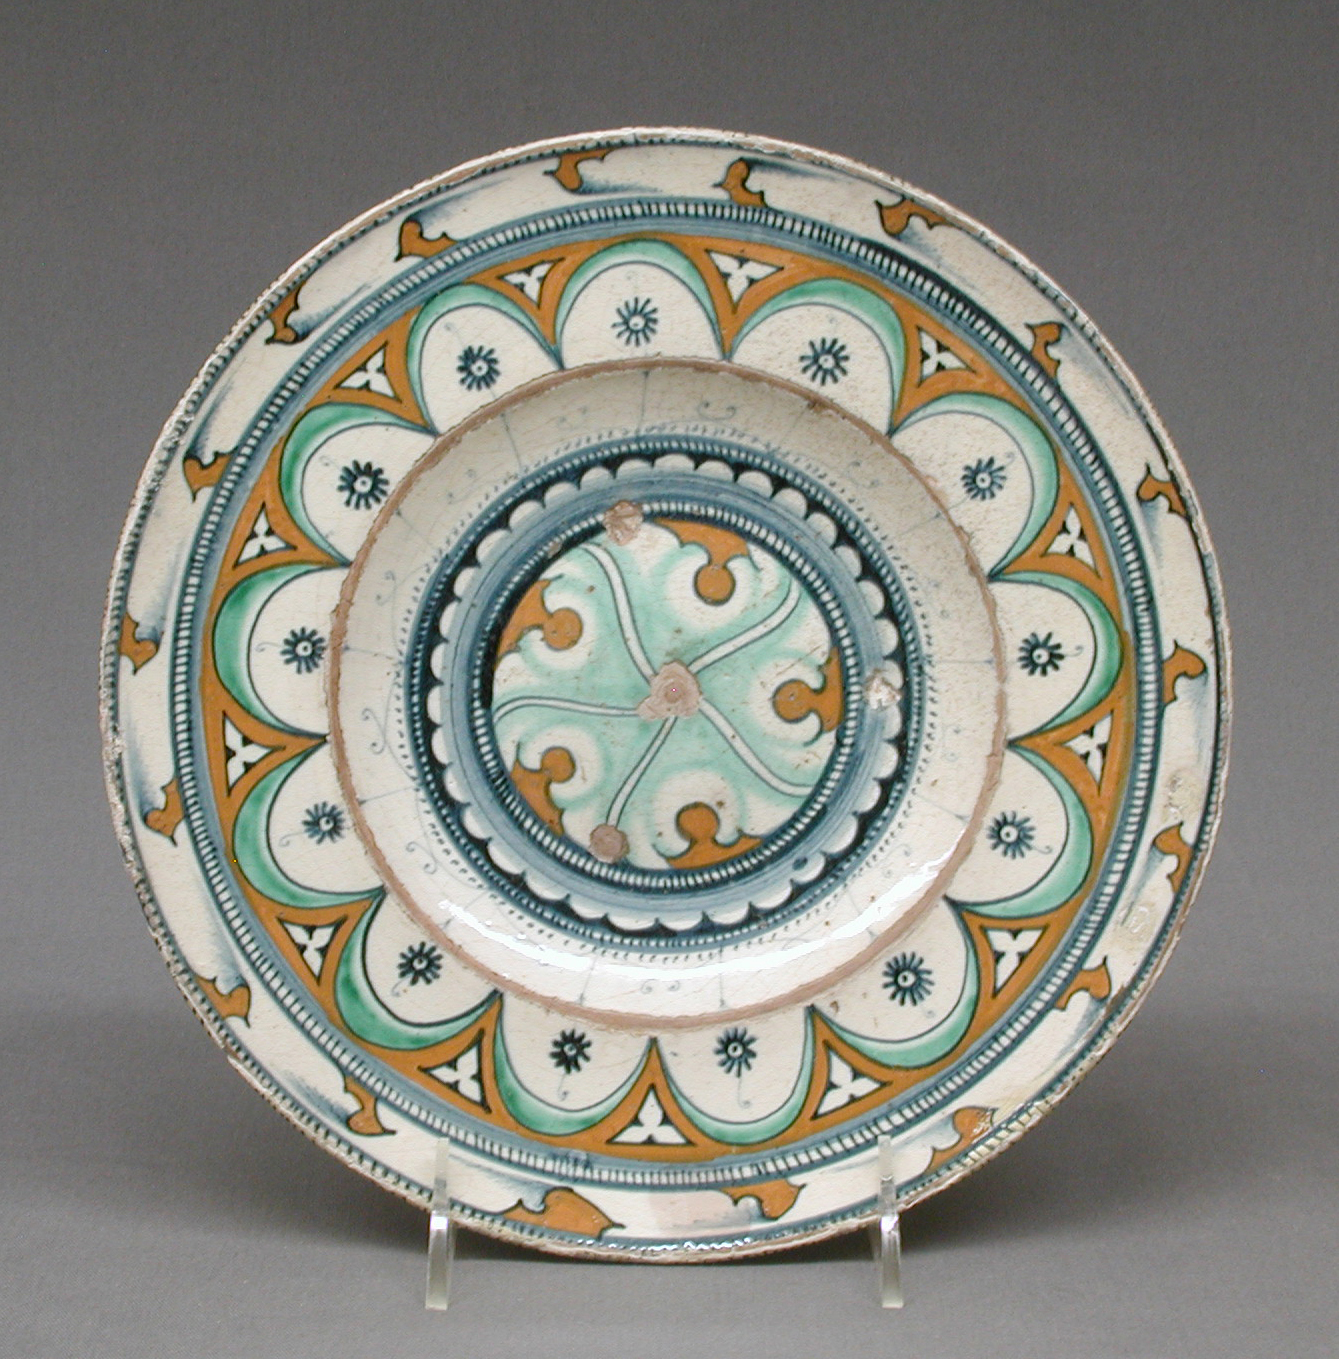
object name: dish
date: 1500-1510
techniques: maiolica, glazing